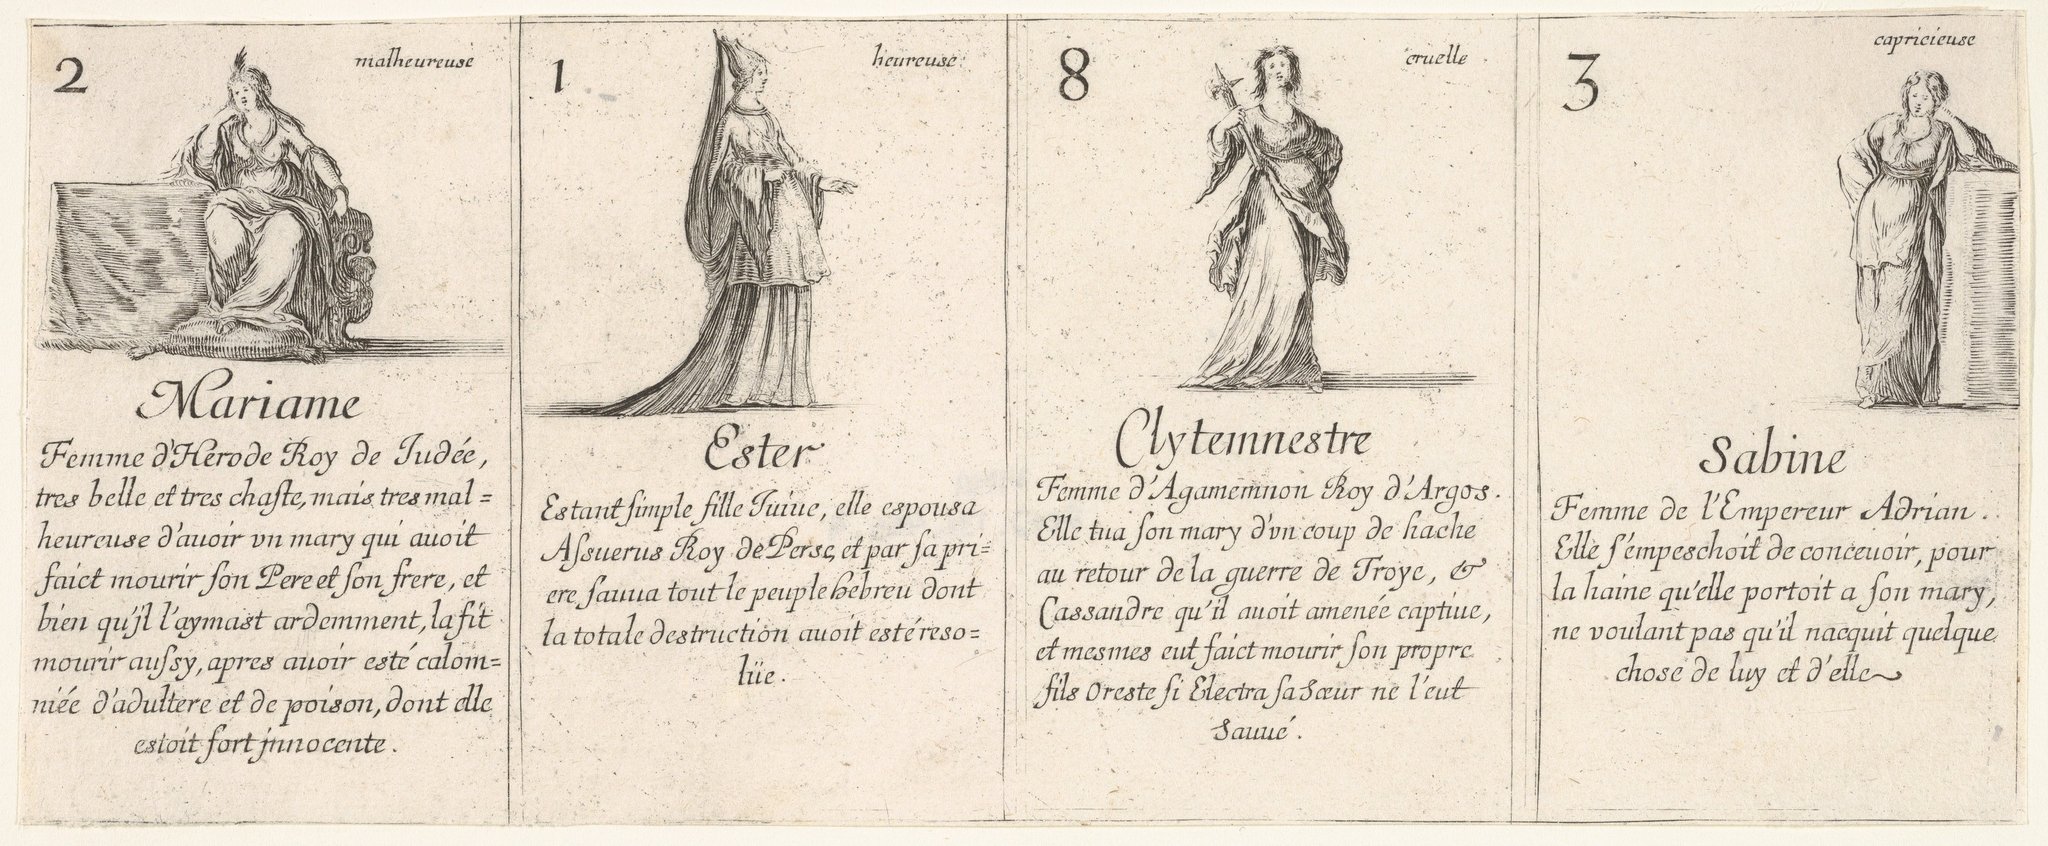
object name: print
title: Mariame, Ester, Clytemnestre, and Sabine, from "The Game of Queens" (Le Jeu des Reines Renommées)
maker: stefano della bella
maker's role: artist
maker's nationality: italian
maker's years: 1610-1664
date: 1644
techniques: etching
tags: queens